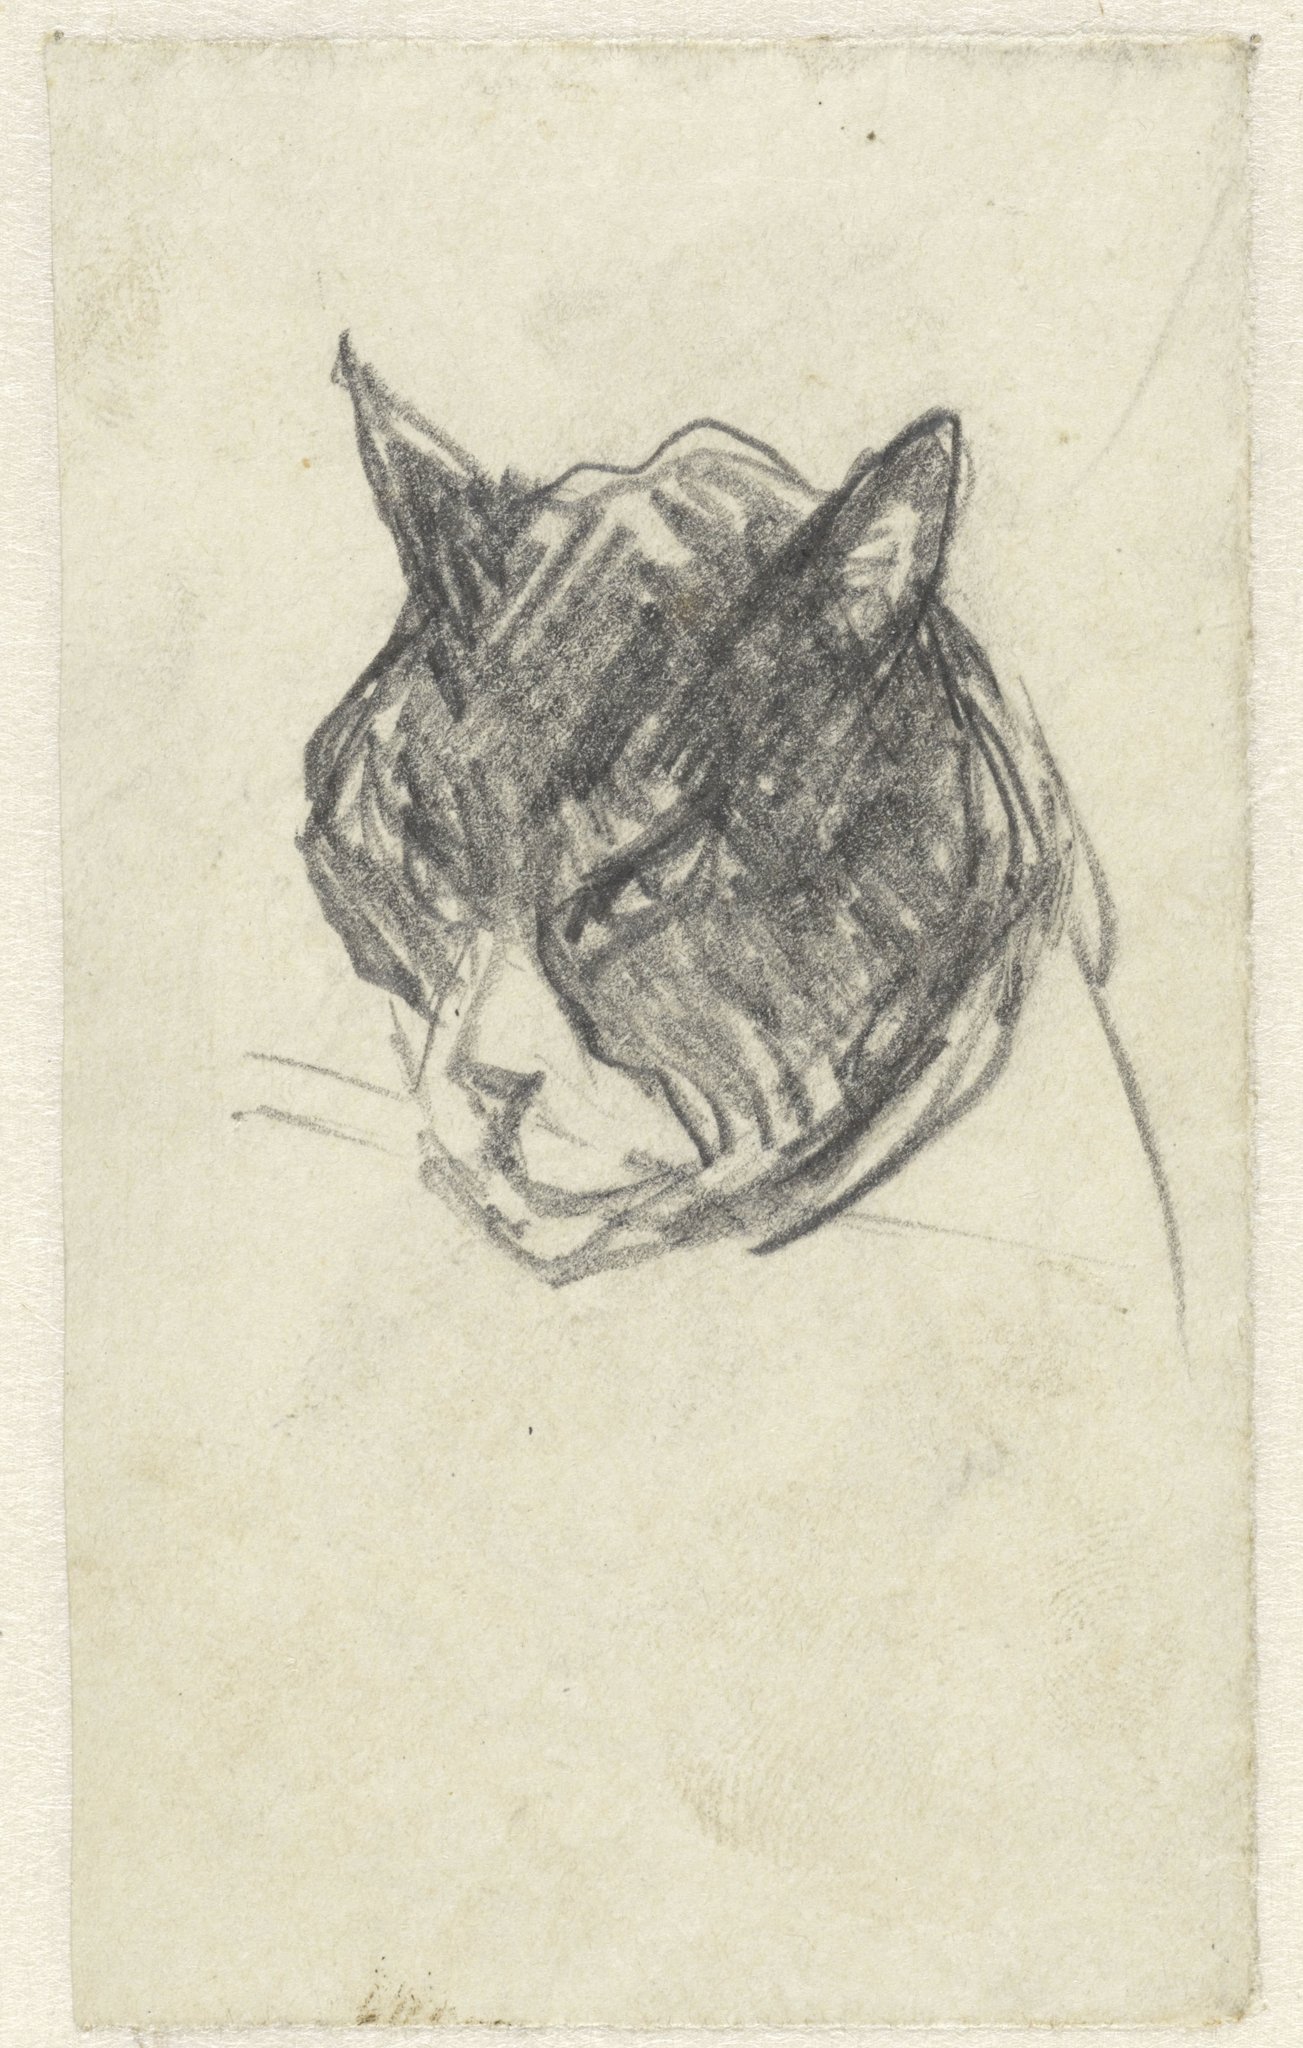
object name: drawing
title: Poes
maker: jac van looij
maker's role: draughtsman, painter, print maker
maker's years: 1855-1930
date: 1865-1930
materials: paper, pencil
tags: cat